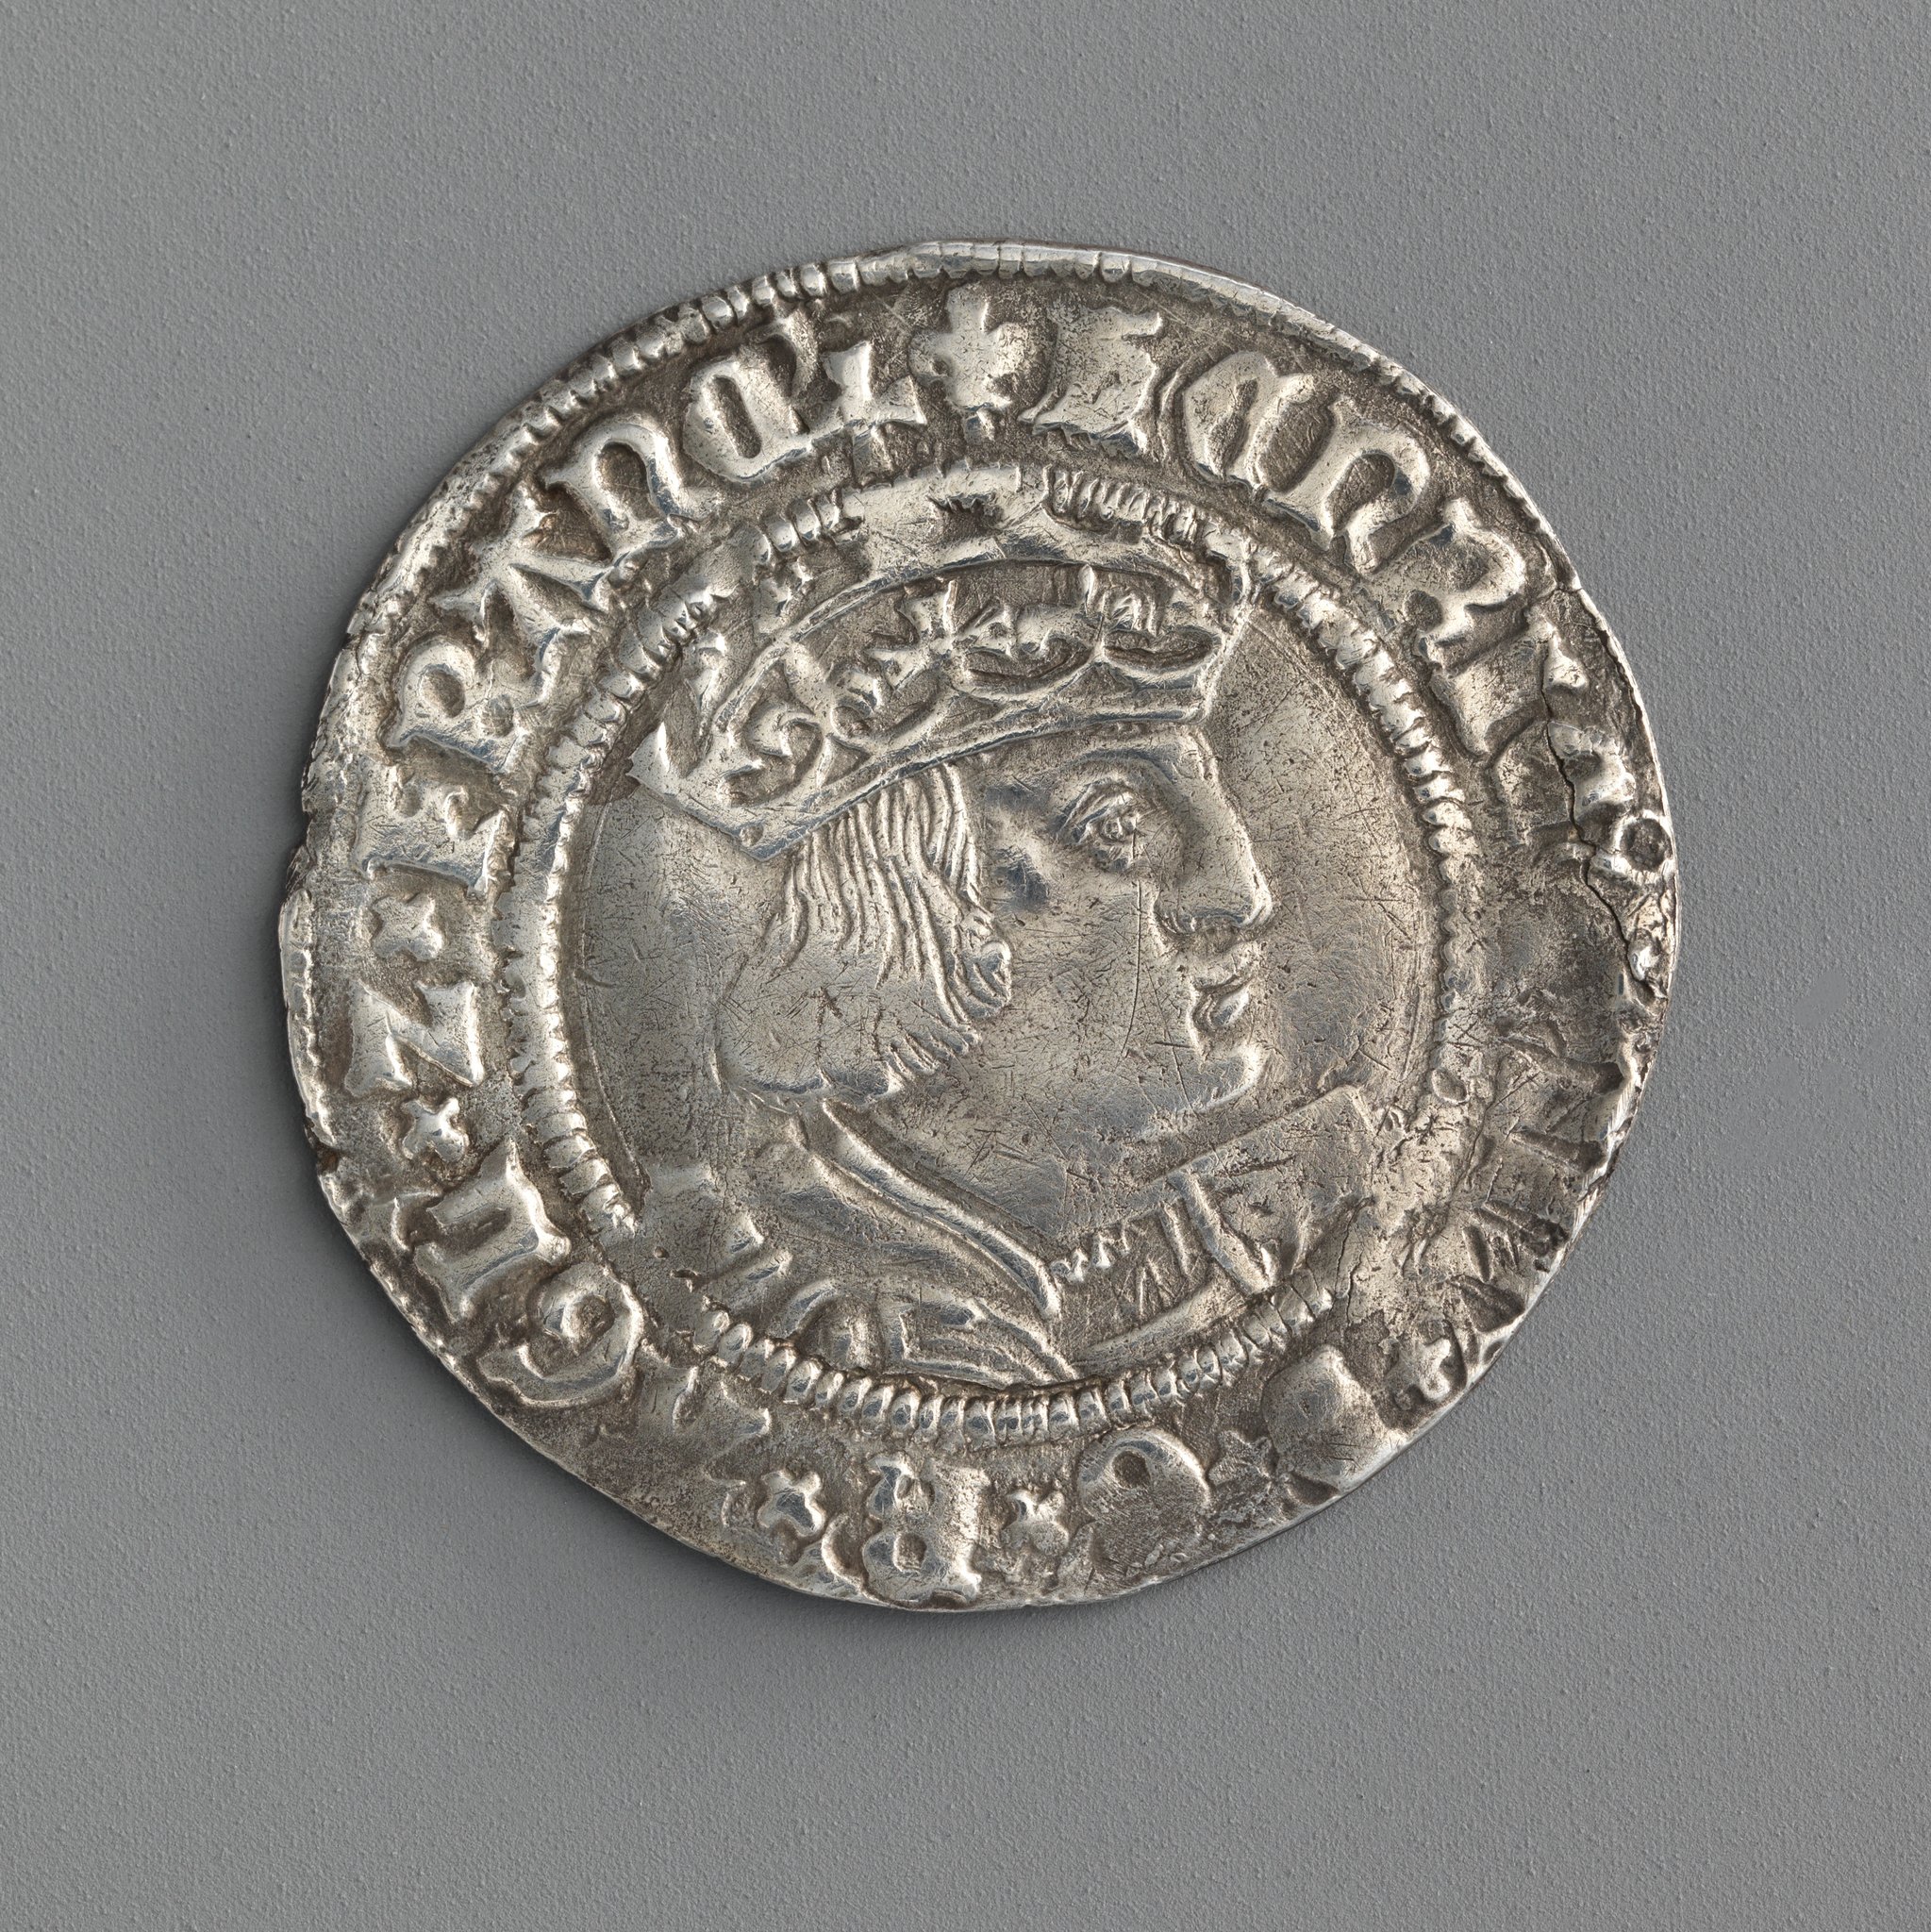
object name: groat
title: Groat of Henry VIII (second coinage)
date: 1526-1530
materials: silver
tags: henry viii,profiles,coat of arms